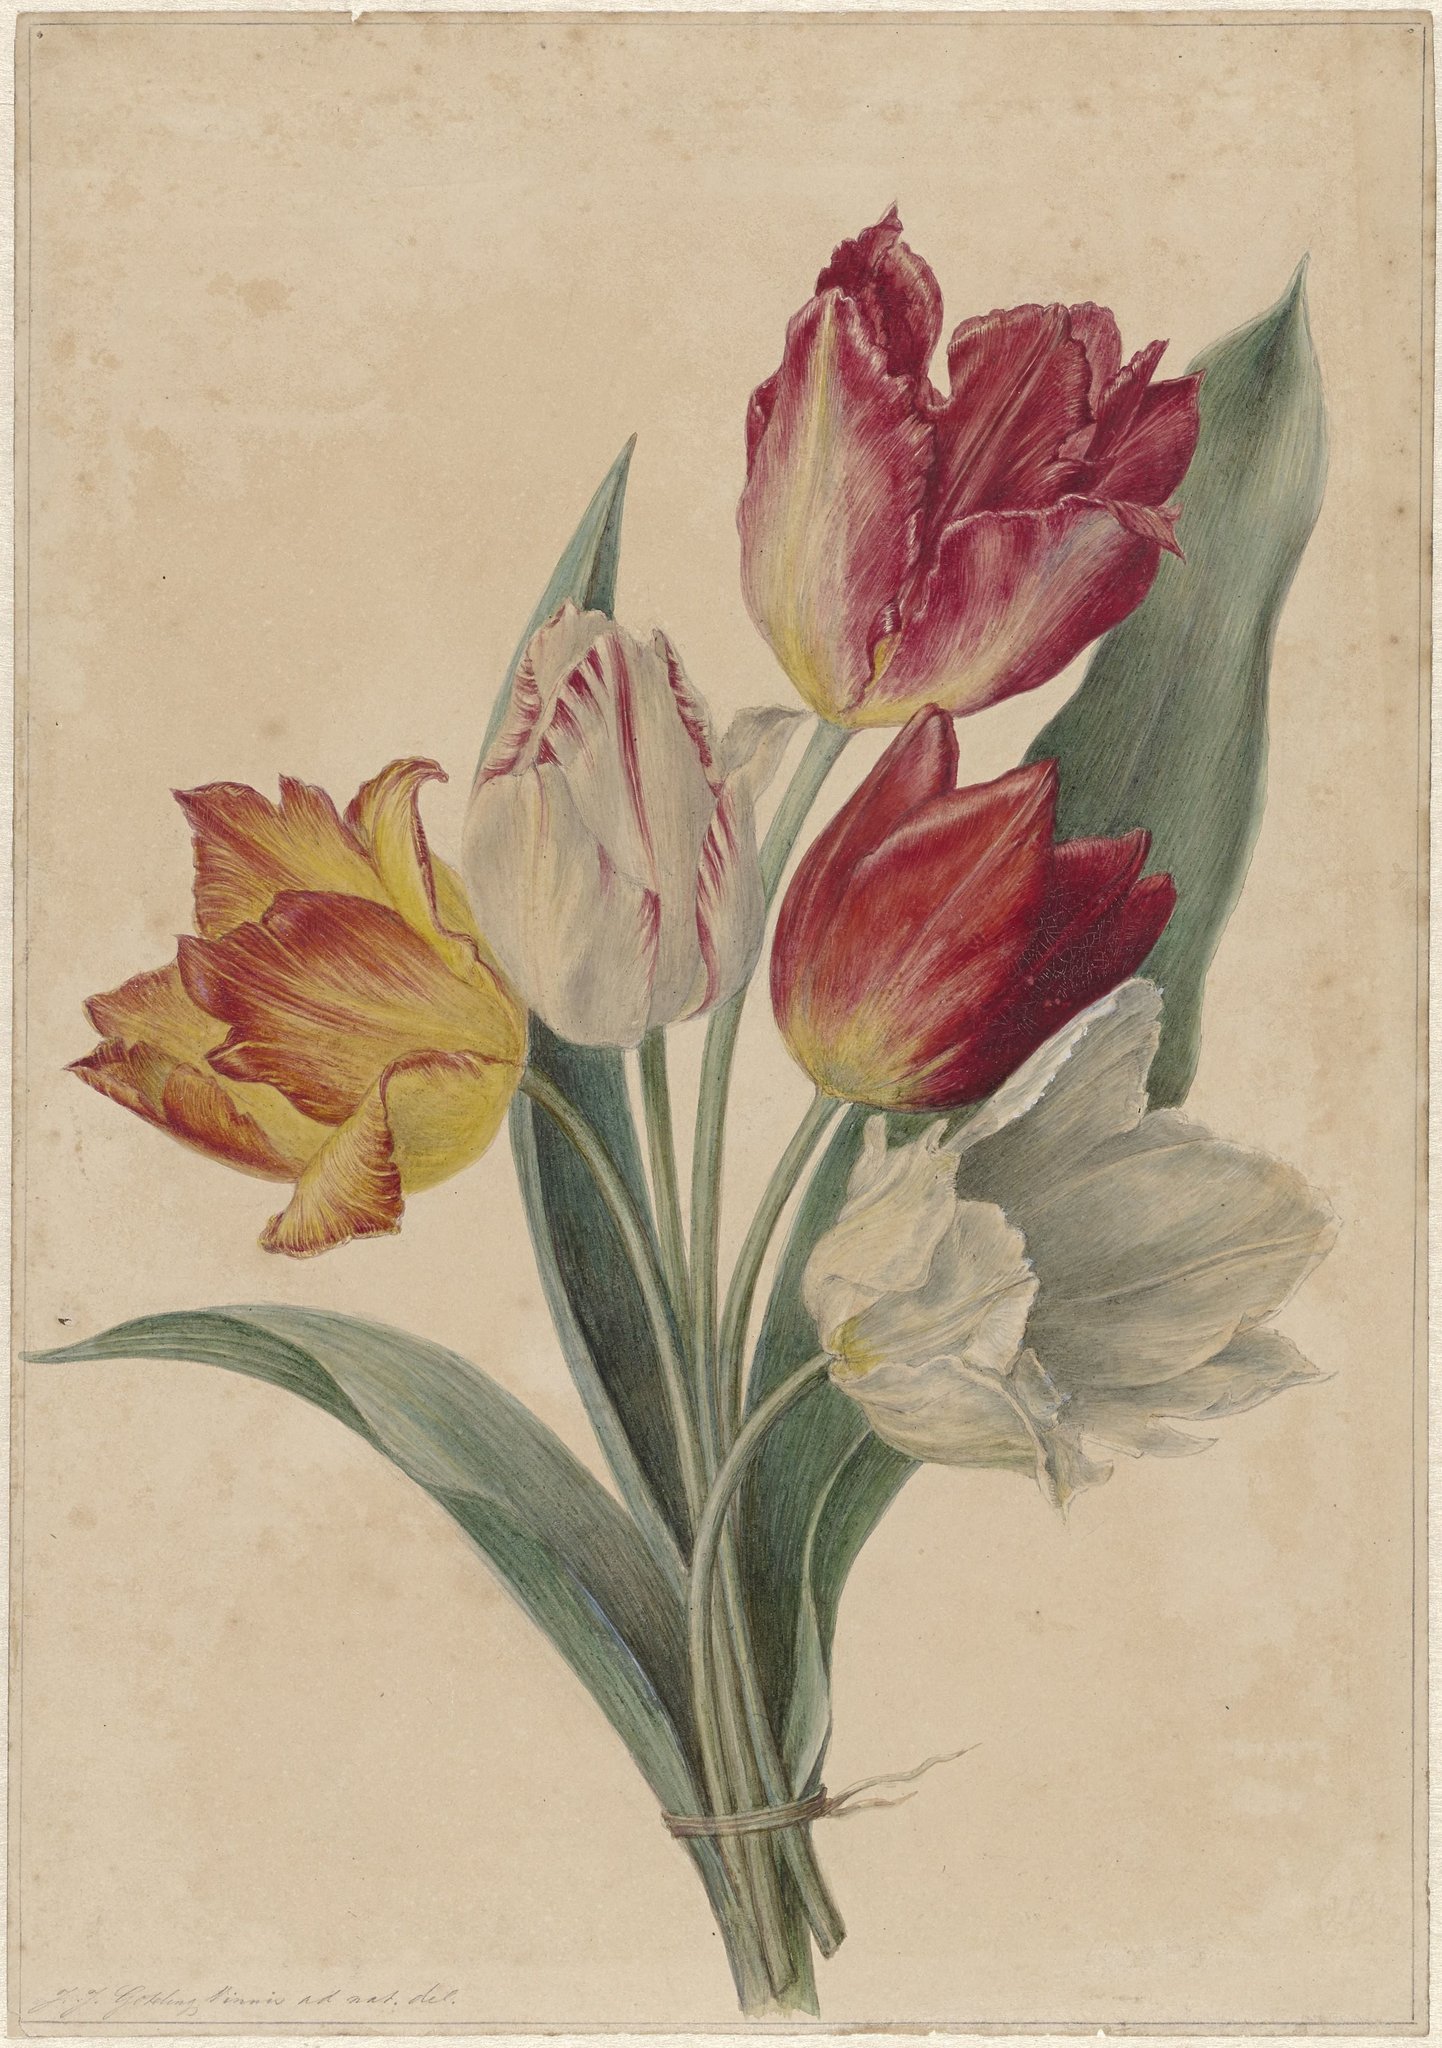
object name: drawing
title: Bouquet of Tulips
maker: jan jacob goteling vinnis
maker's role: draughtsman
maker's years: 1821-1900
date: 1831-1900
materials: paper, pencil, watercolor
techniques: brush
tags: flowers: tulip